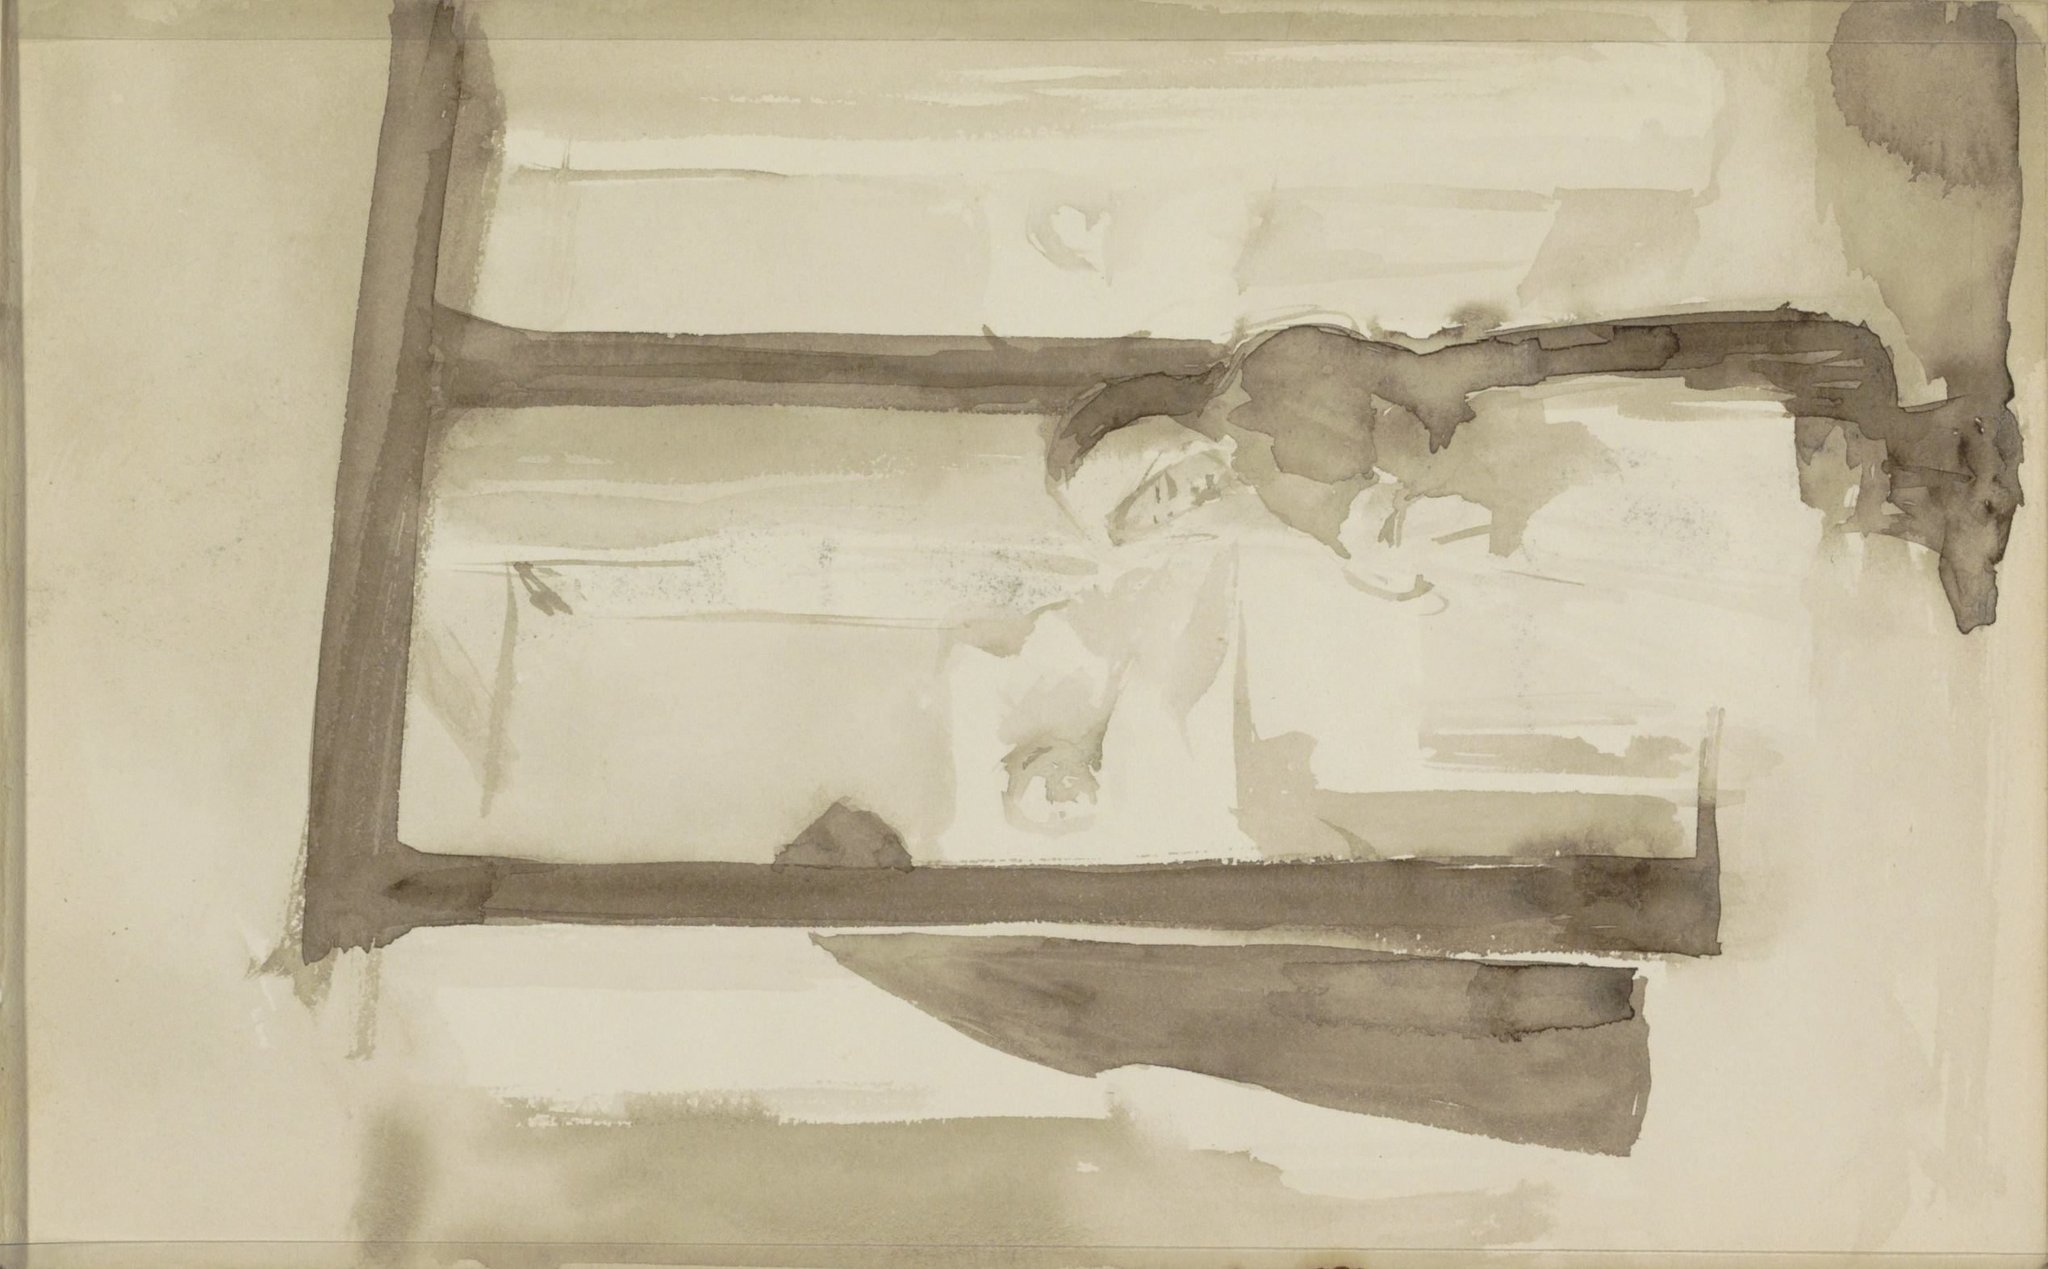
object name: sketchbook leaf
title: Interieur met een meisje en vrouw bij een man op een ziekbed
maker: a.a.l. de grammont-hubrecht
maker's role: draughtsman, painter, print maker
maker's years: 1855-1913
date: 1892-1913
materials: ink, paper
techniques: brush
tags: standing figure, sick-bed, girl (child between toddler and youth), interior of the house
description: Blad 28 recto uit een schetsboek met 31 bladen.